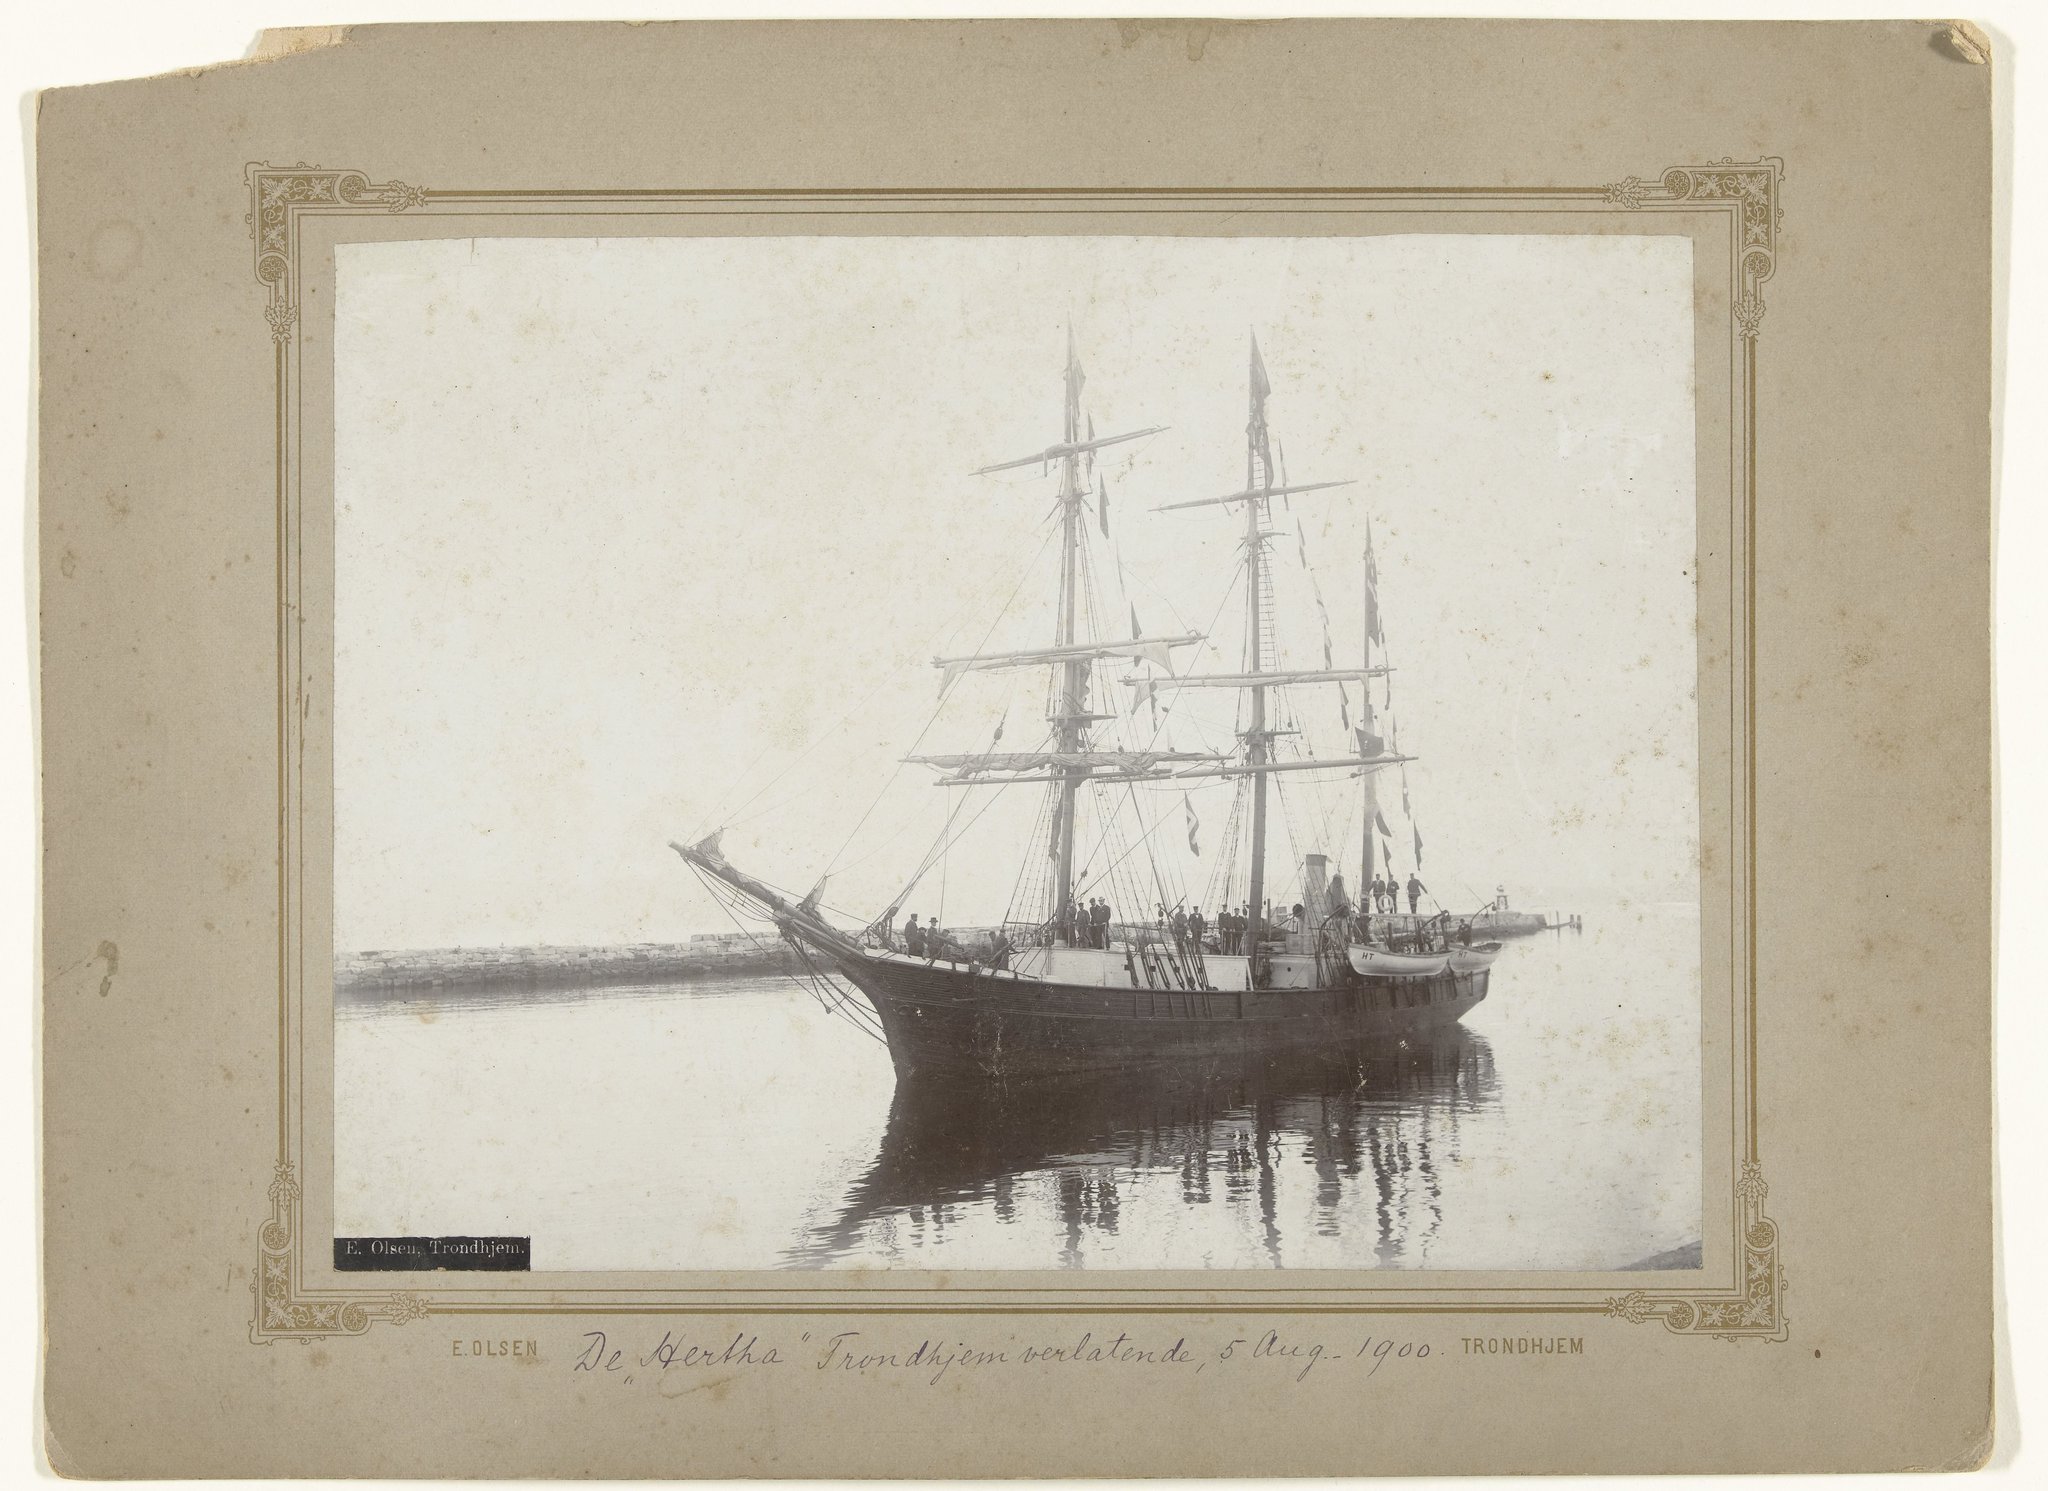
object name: photograph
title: Het zeilschip Hertha bij het verlaten van de haven van Trondheim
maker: erik olsen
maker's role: fotograaf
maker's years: 1835-1920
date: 1900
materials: cardboard, photographic support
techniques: gelatin silver print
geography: trondheim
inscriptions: signature: ‘E. Olsen, Trondhjem.’, annotation: ‘De "Hertha" Trondhjem verlatende, 5 Aug. - 1900’, signature: ‘E. OLSEN TRONDHJEM’